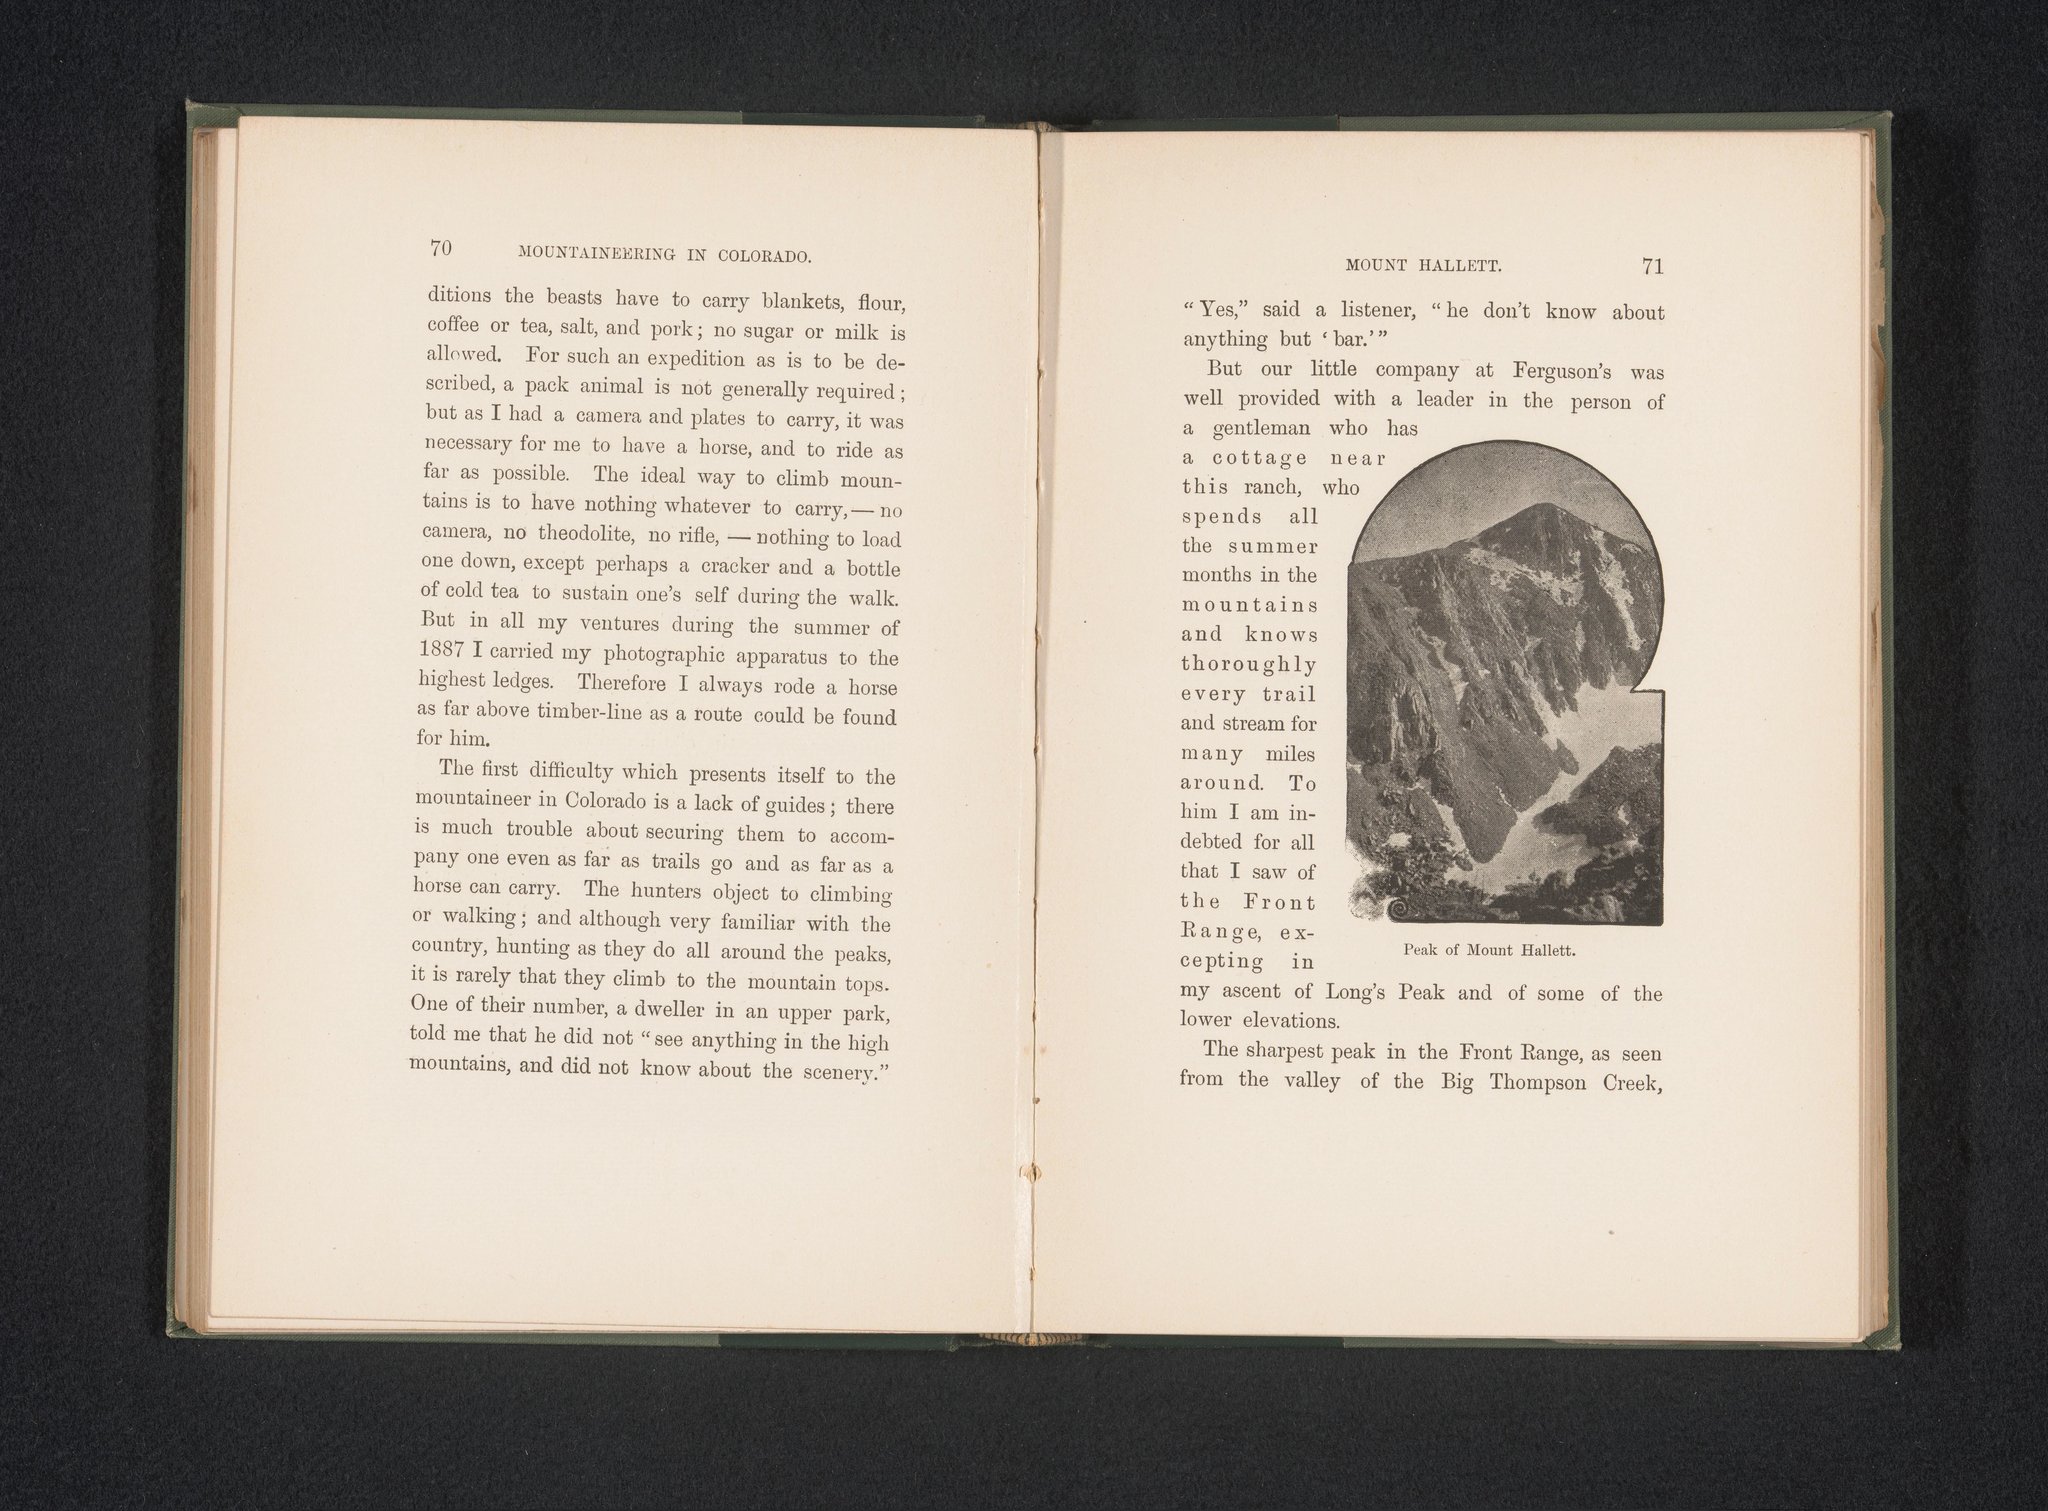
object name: photomechanical print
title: Peak of Mount Hallett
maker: frederick hastings chapin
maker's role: antropoloog, archeoloog, fotograaf, schrijver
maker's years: 1852-1900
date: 1885-1890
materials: paper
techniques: autotype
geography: boston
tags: mountain-top, peak, wildlife reserve, national park, mountains